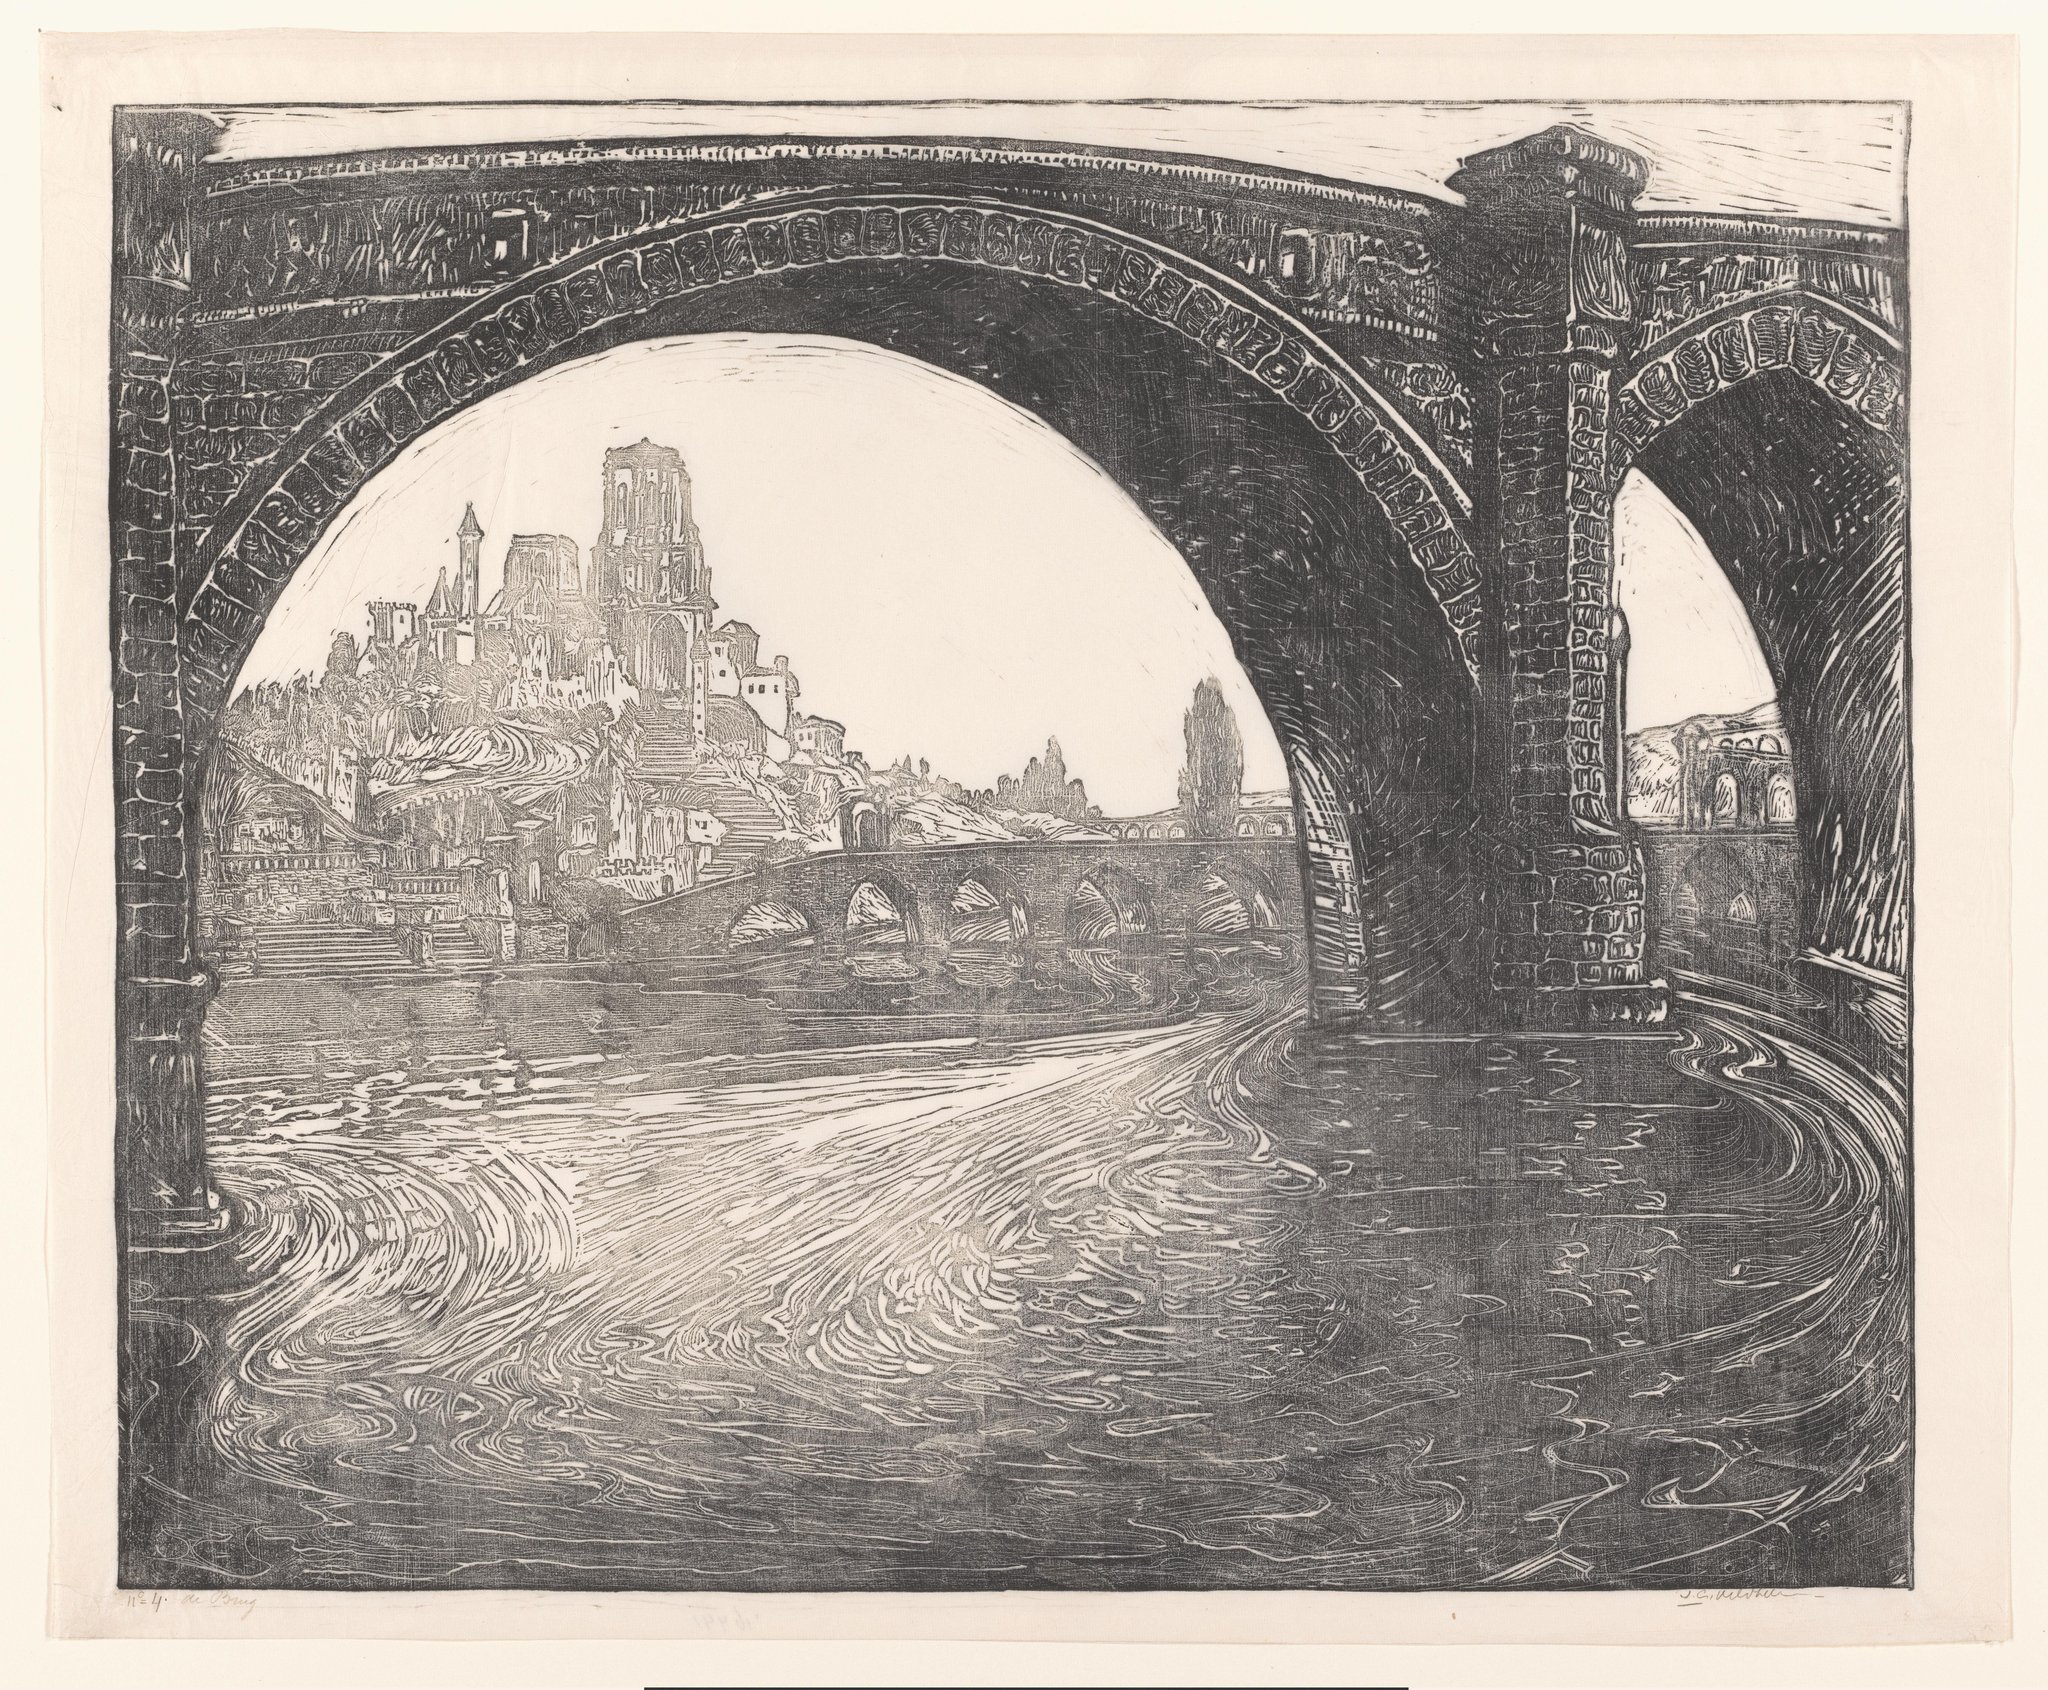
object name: print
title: De Brug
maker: jacobus gerardus veldheer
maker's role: draughtsman, print maker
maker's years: 1866-1954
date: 1876-1916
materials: paper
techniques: woodcut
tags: castle, bridge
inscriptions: number: ‘no. 4’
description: Gezicht onder een brug door op een heuvel met burcht.